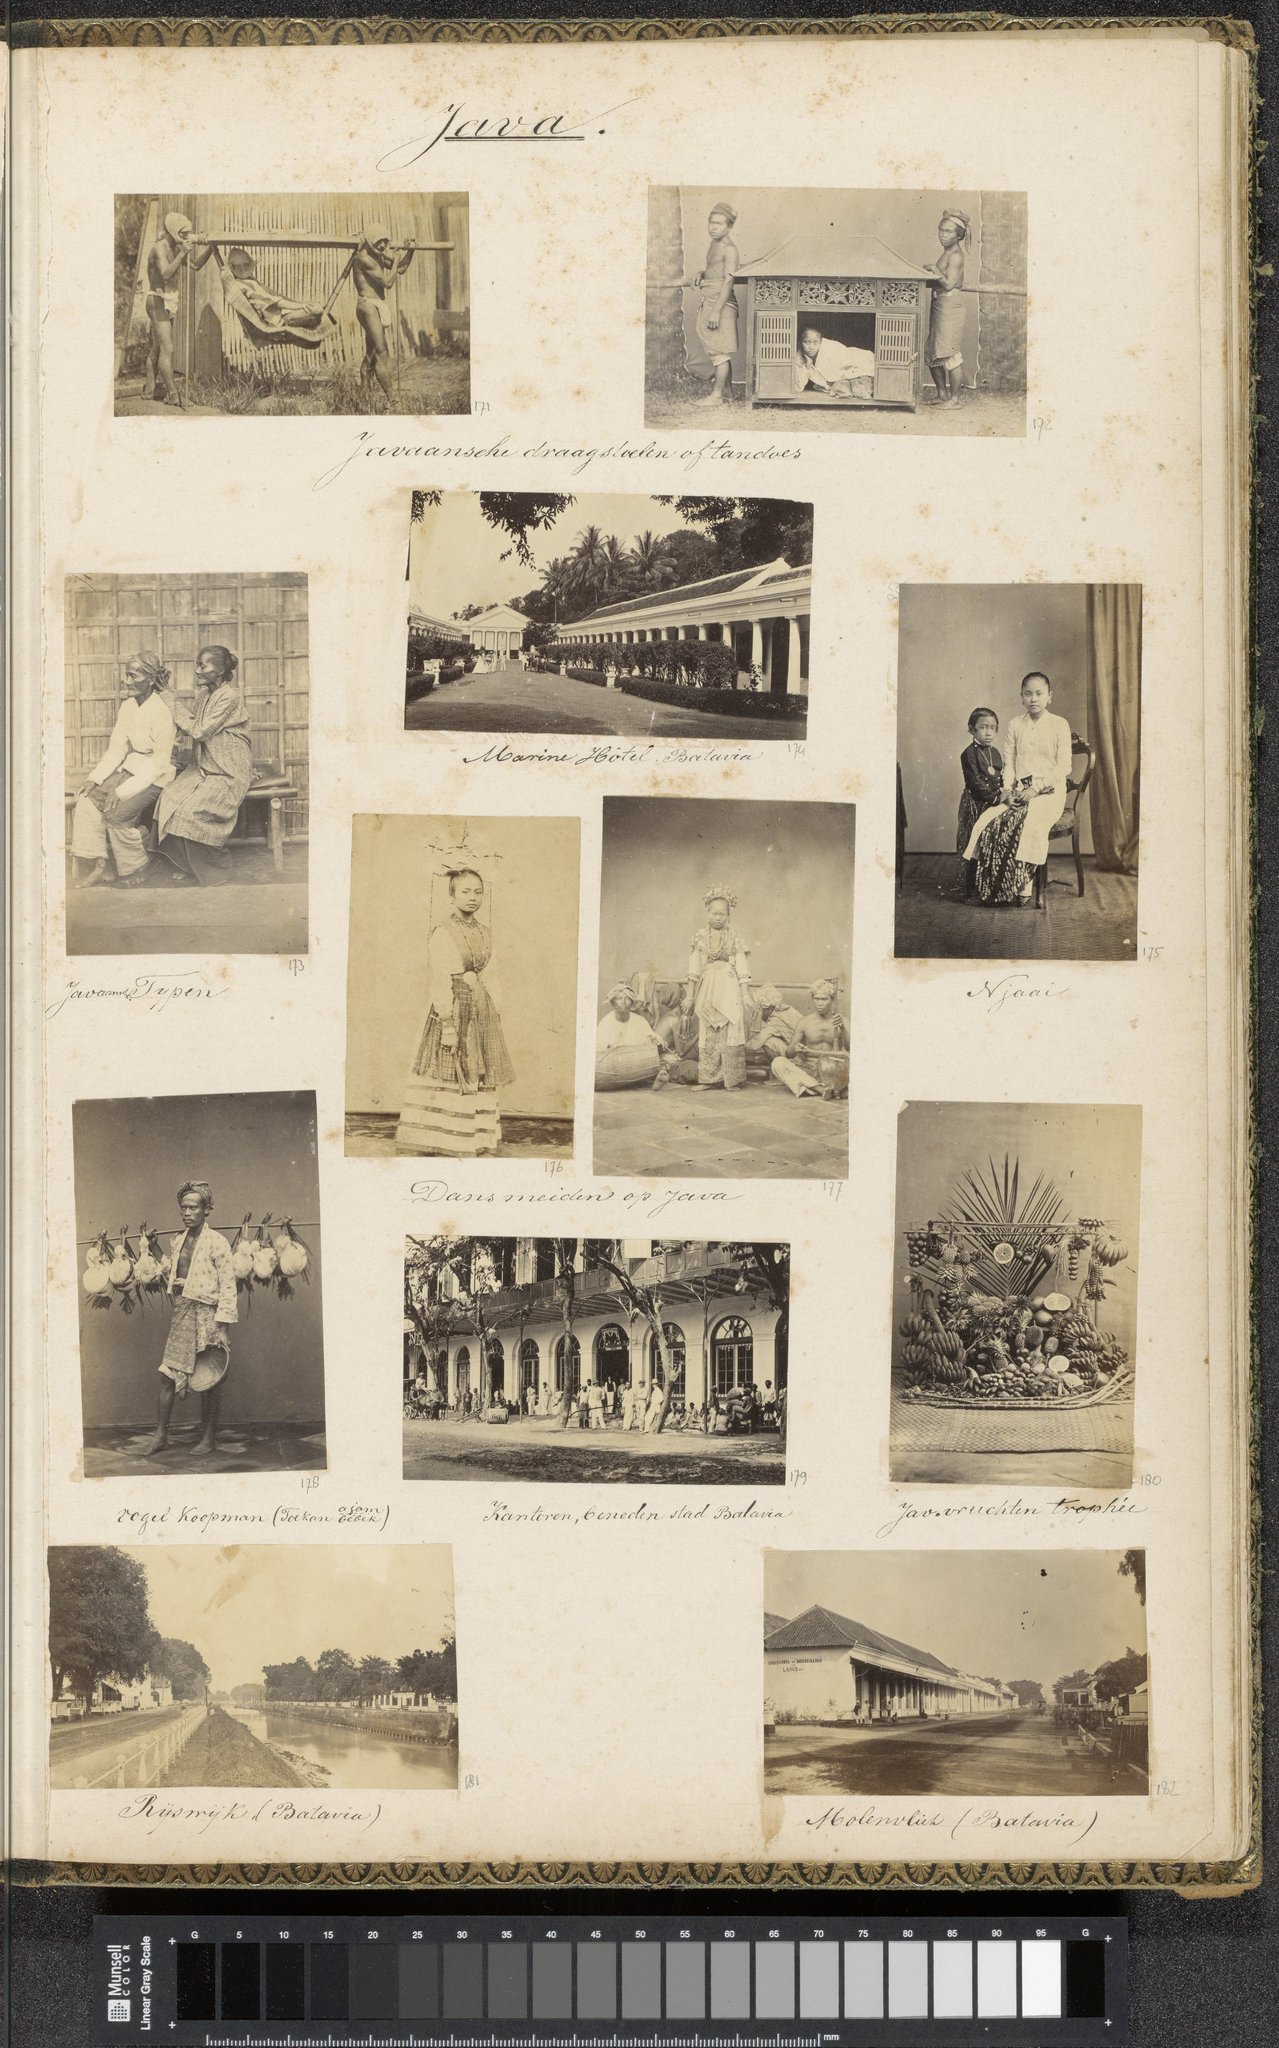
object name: photograph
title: Groepsportret van een Javaans orkest met danseres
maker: Anonymous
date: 1870-1880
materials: paper, photographic support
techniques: albumen print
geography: java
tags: small group of musicians, chamber orchestra, jazz band, portrait of dancer, java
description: Onderdeel van Fotoalbum van Robert Daniel Crommelin (1841-1907).